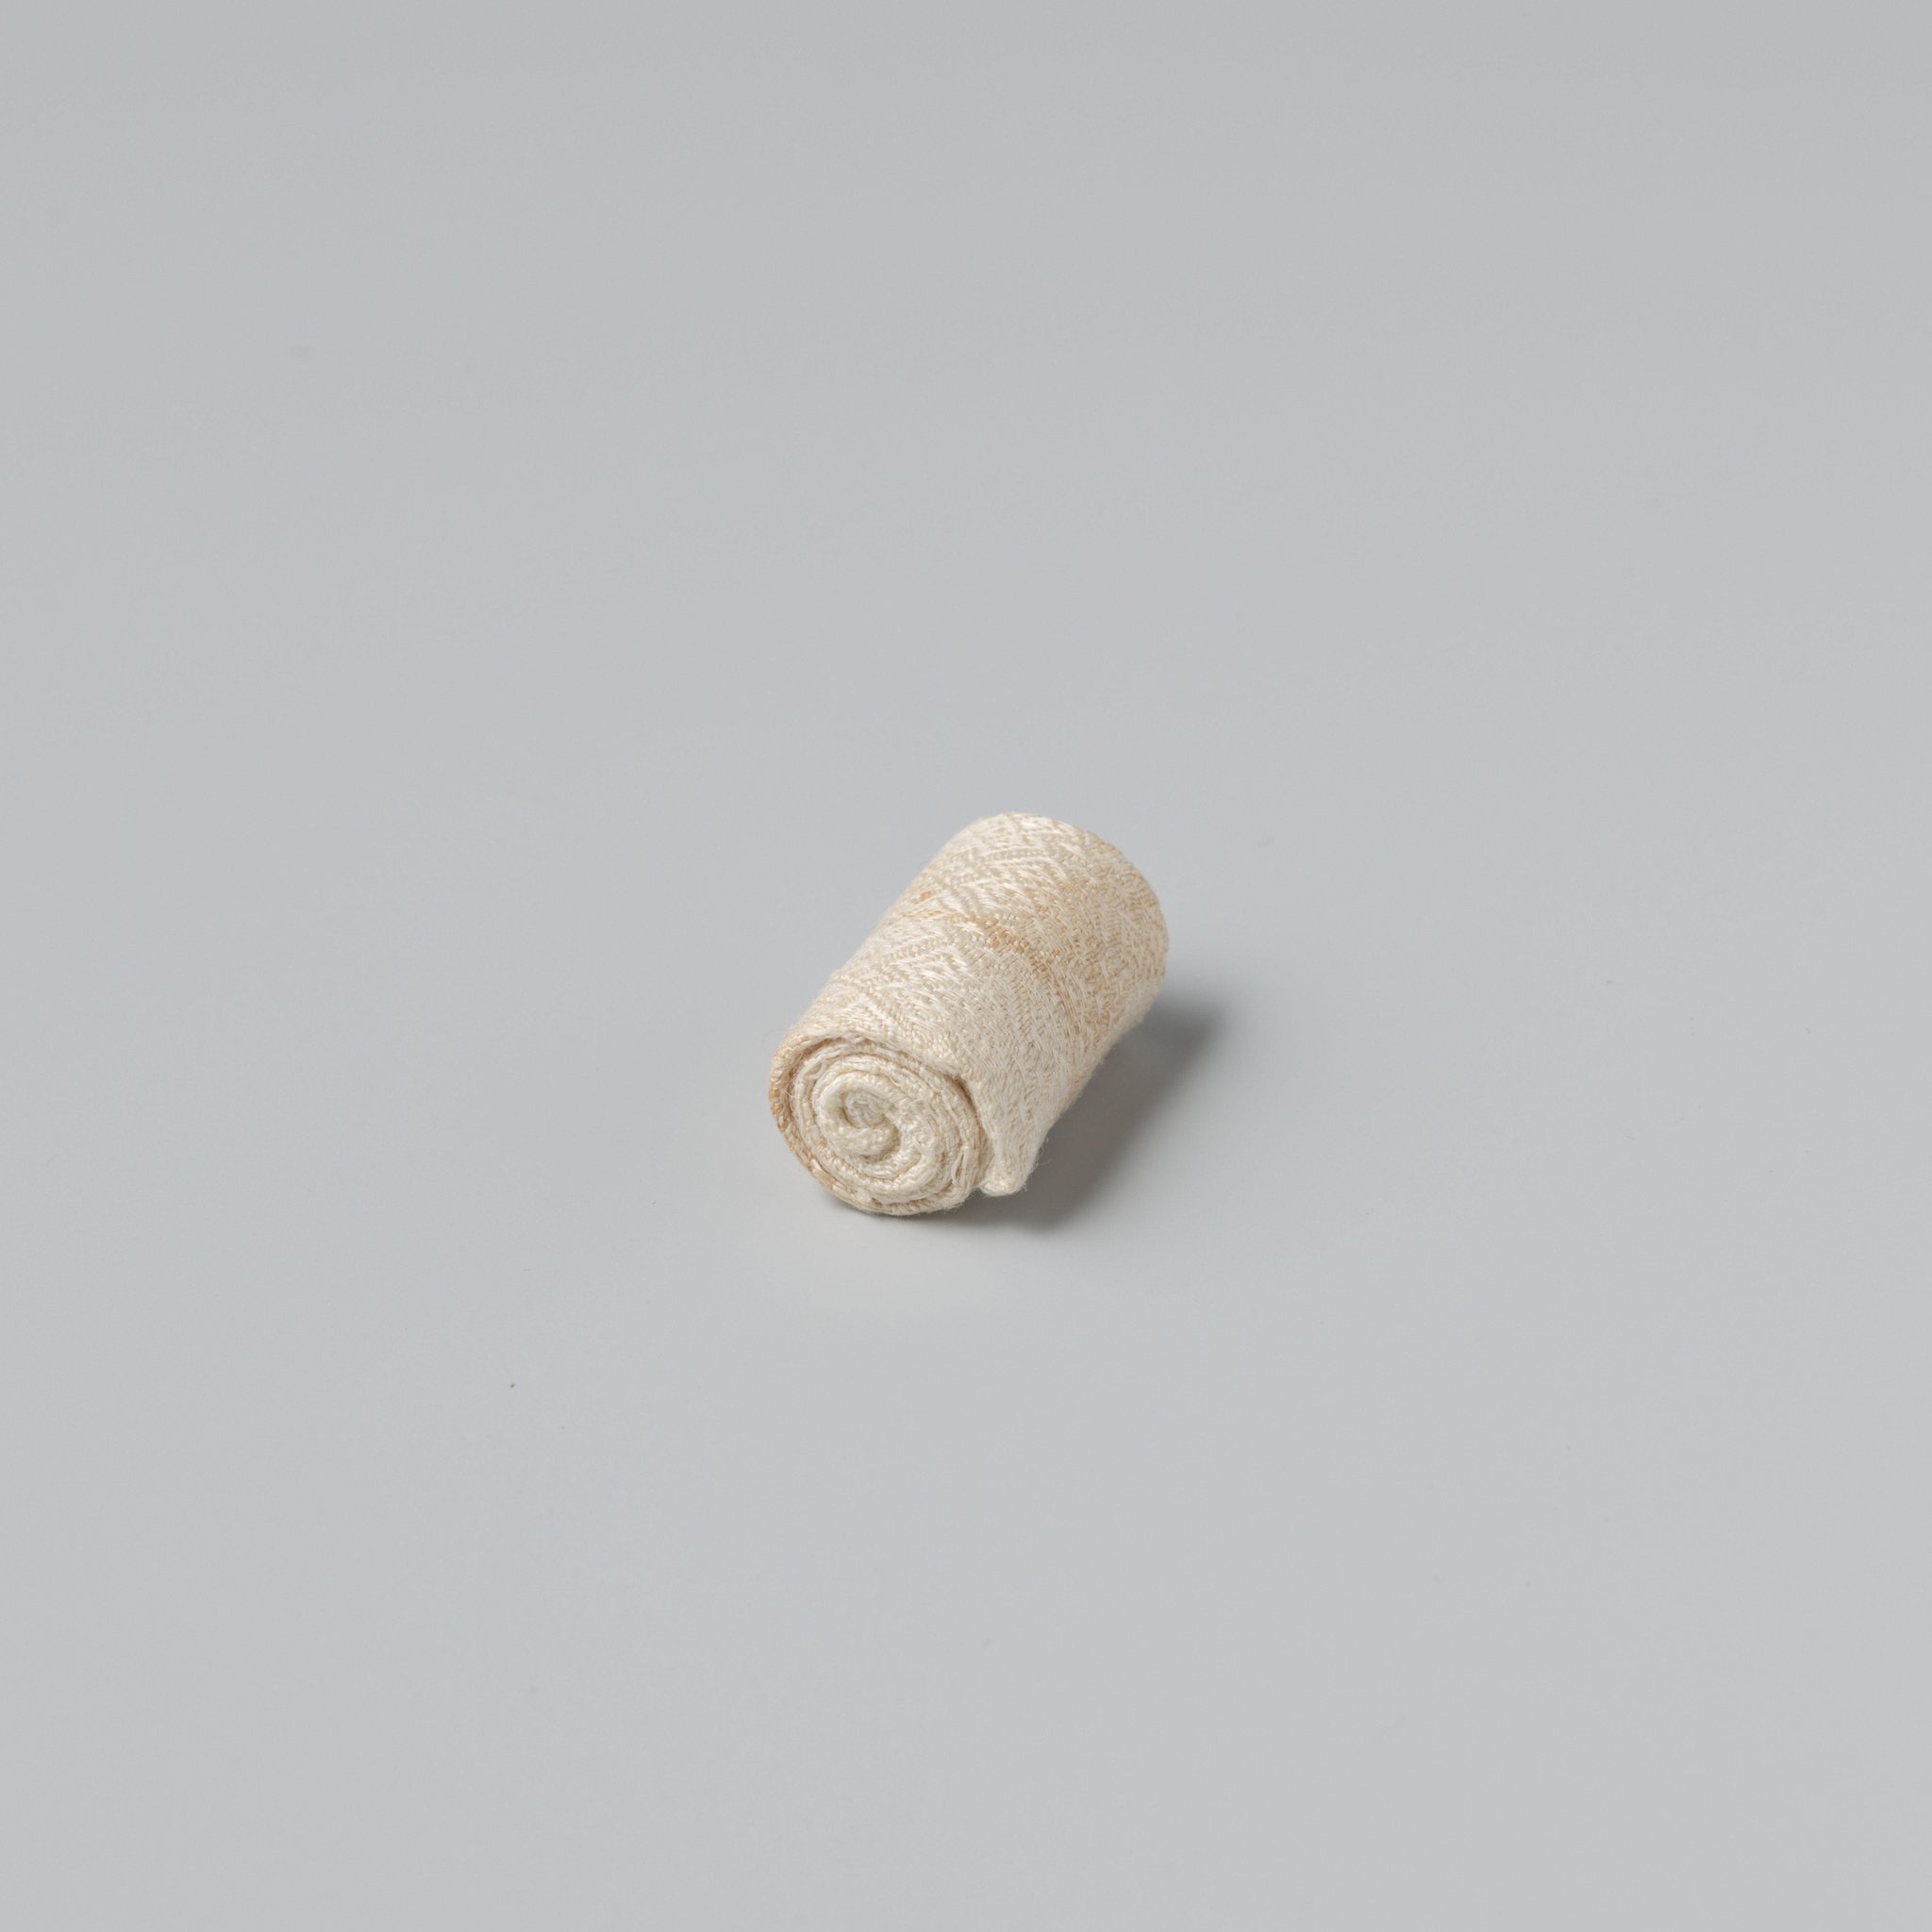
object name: miniature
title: Rol linnen, damastweefsel met pellenpatroon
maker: Anonymous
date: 1600-1699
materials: linen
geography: netherlands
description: Rol linnen, damastweefsel met pellenpatroon.